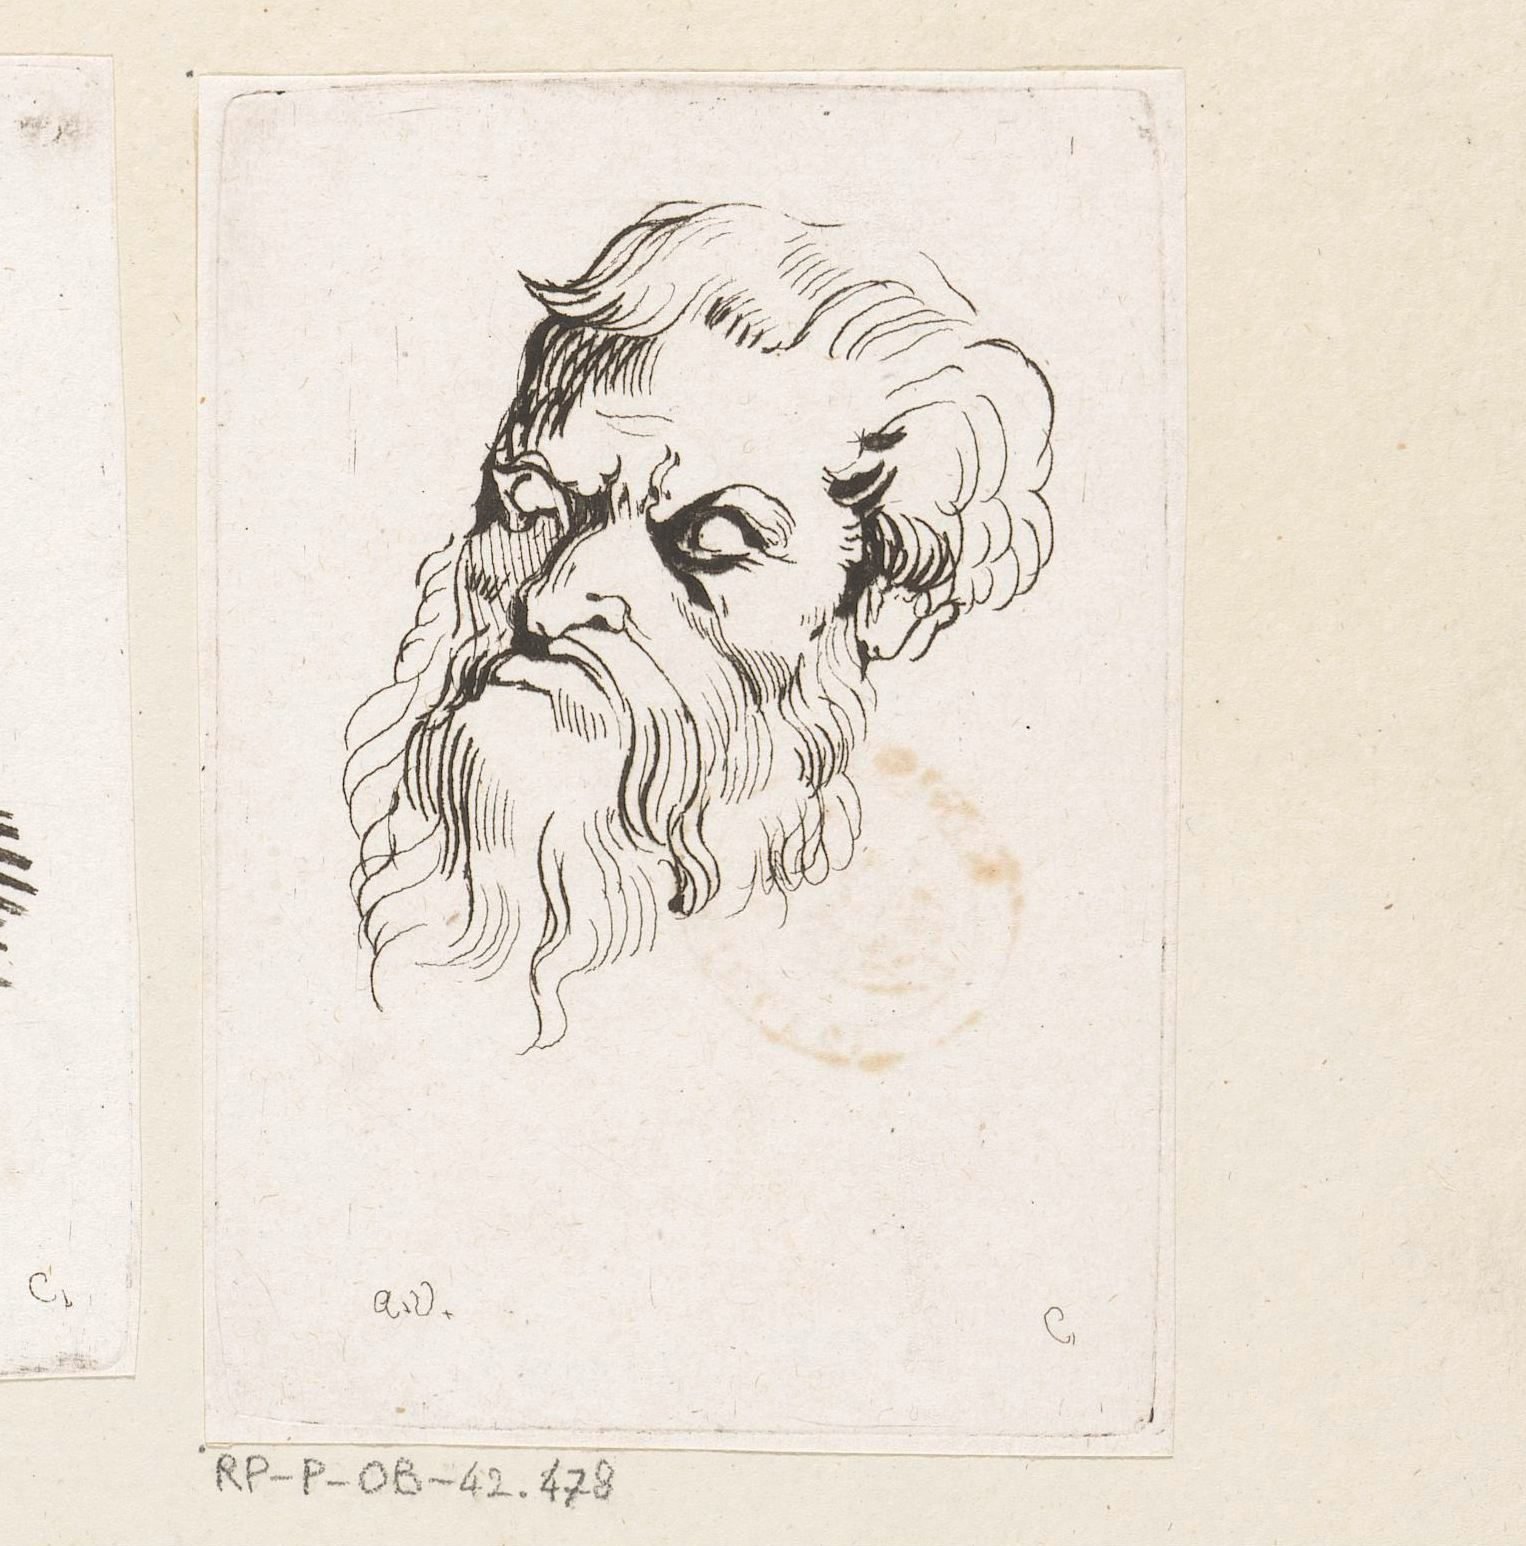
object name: print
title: Hoofd van een man met baard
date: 1735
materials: paper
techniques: etching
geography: france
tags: head (human), old man, beard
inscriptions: collector's mark: Lugt 240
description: Prent uit een serie van 31 prenten naar getekende hoofden door Van Dyck, plus een titelprent naar Bouchardon, getiteld: "Recueil de Testes d'Antoine Van Dyck tirées du Cabinet de M. Crozat et gravées par M. le C. de C.".